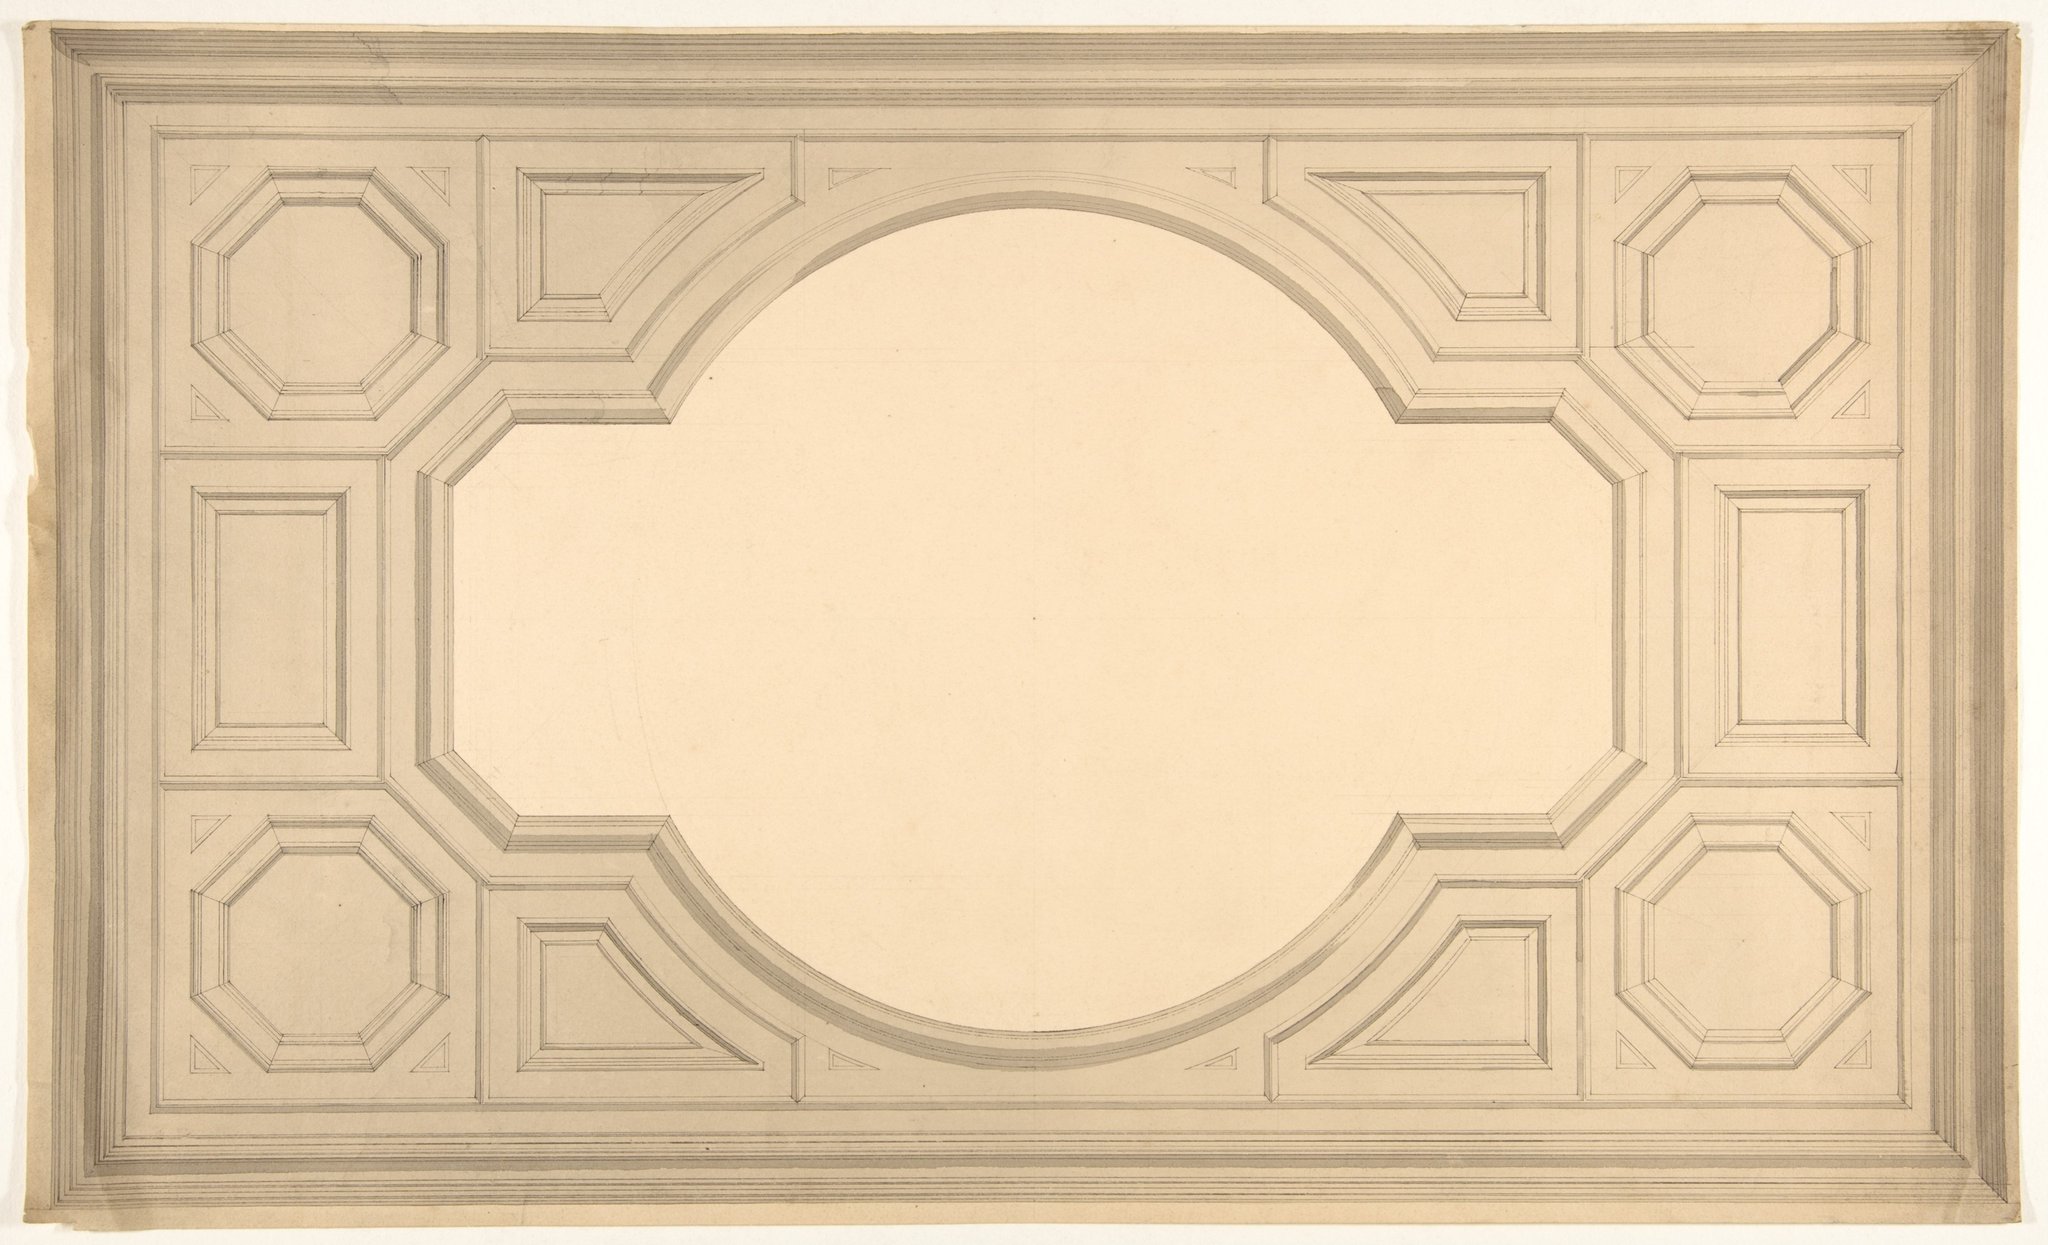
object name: drawing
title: Design for a ceiling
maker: jules-edmond-charles lachaise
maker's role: artist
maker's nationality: french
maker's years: 1897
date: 1851-1900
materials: graphite, ink, watercolor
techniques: pen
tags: ceilings